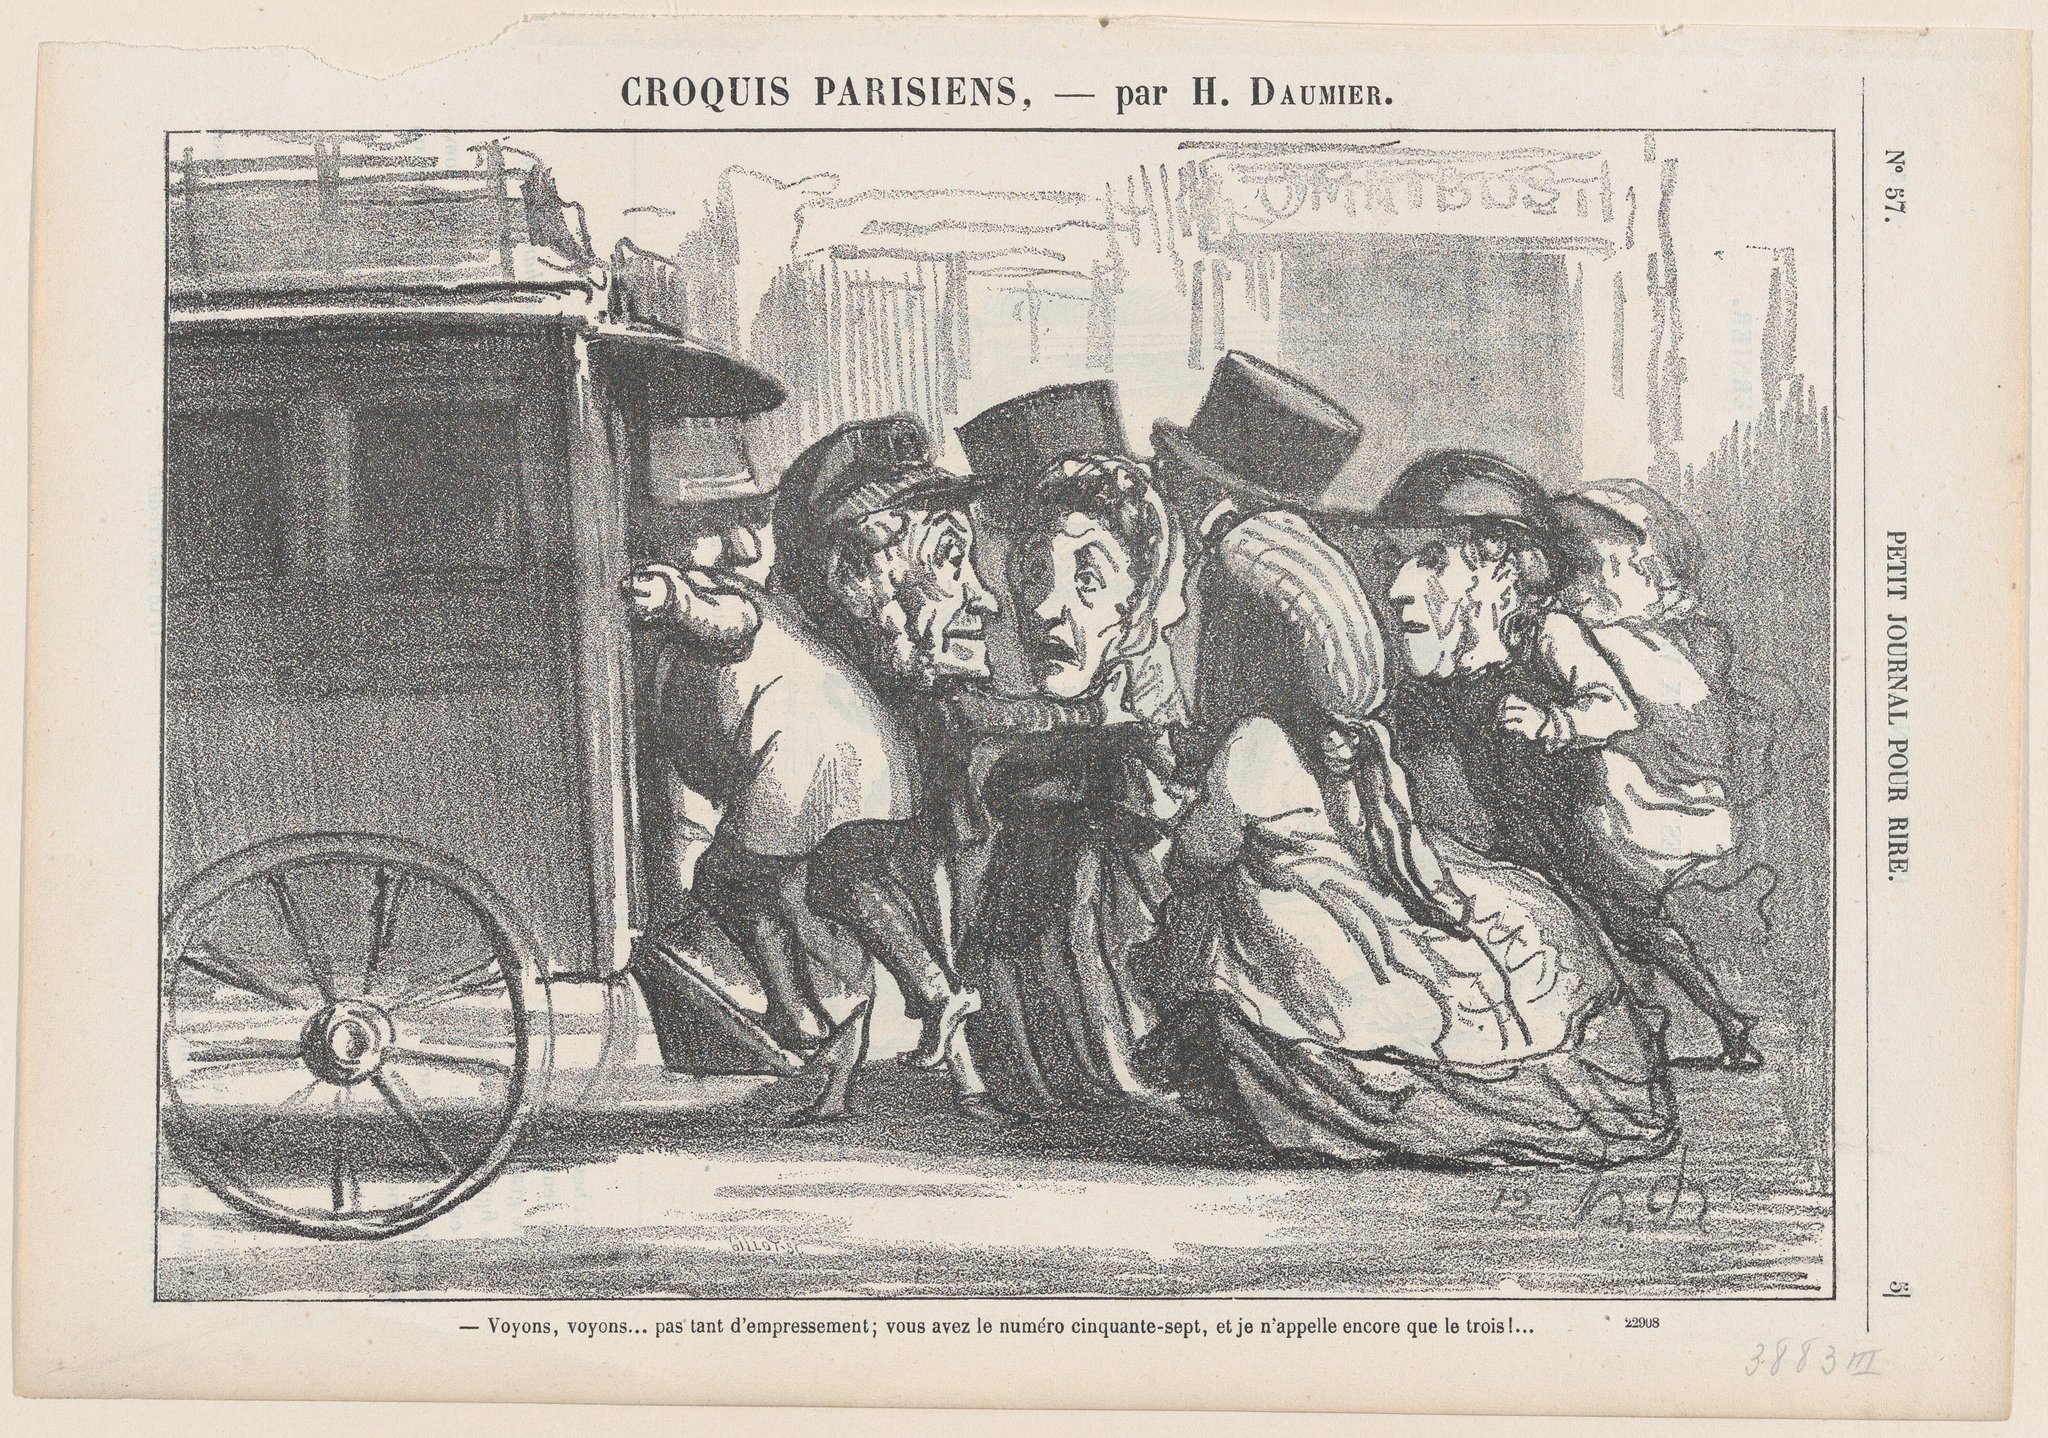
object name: print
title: Stop pushing please... you have the number 57 and I just called number 3!, from "Parisian Sketches"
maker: honoré daumier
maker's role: artist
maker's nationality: french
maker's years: 1808-1879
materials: paper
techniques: lithograph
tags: satire,men,women